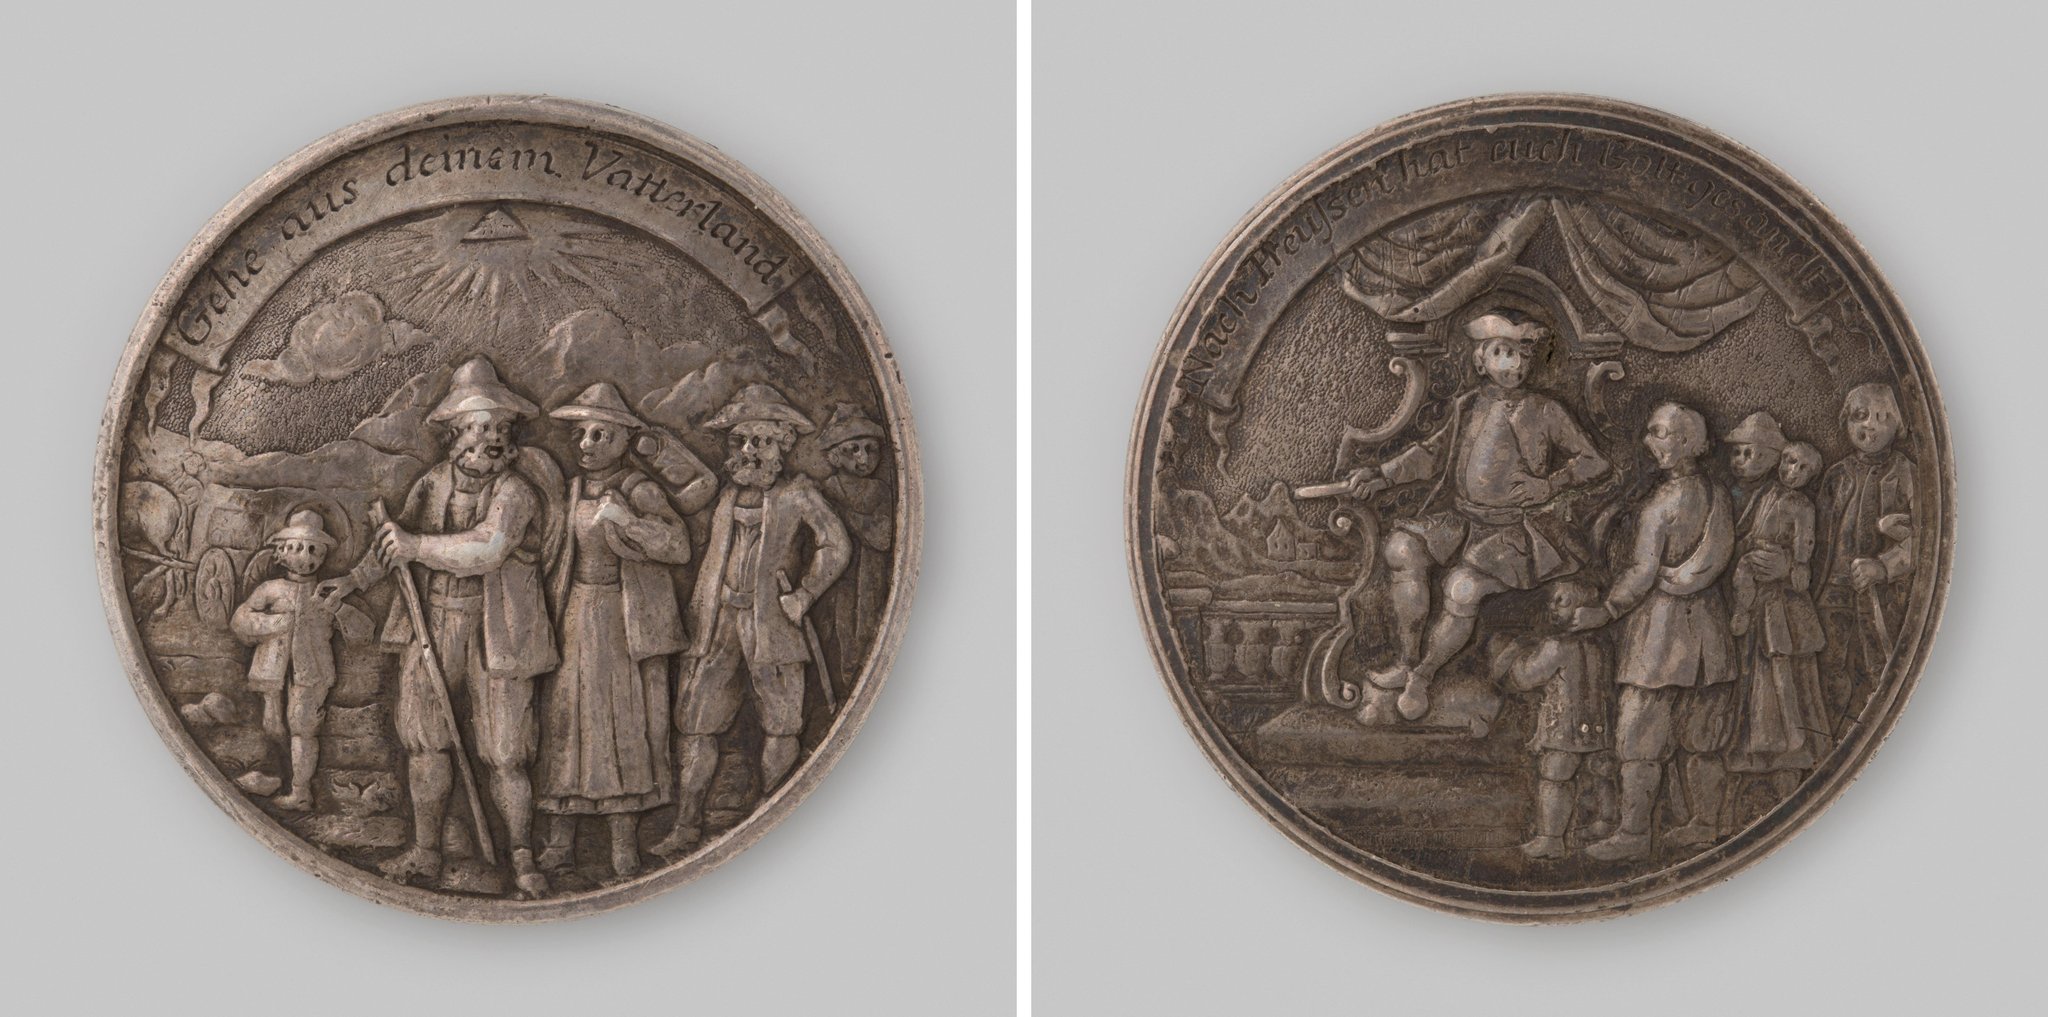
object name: box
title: Aankomst Salzburger emigranten in Pruisen 1732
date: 1732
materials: silver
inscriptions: hallmark: ‘dolfijn’, inscription: ‘Nach Preussen hat euch Gott gesandt’, inscription: ‘Gehe aus deinem Vatterland’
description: Zilveren schroefdoosje met beiderzijds een afbeelding in reliëf, op het deksel een groep landverhuizers in berglandschap onder het oog Gods, bovenaan een lint met gegraveerde tekst, op de bodem de landverhuizers voor de getroonde Pruisische koning die hen een dorp wijst, eveneens onder een lint met gegraveerde tekst. Aan de binnenzijden gedrukte landkaarten, in het deksel van Salzburg, in de bodem van Litouwen. In het doosje 17 handmatig polychroom ingekleurde en genummerde ronde prentjes (oorspronkelijk verbonden geweest) met taferelen van de verhuizing.